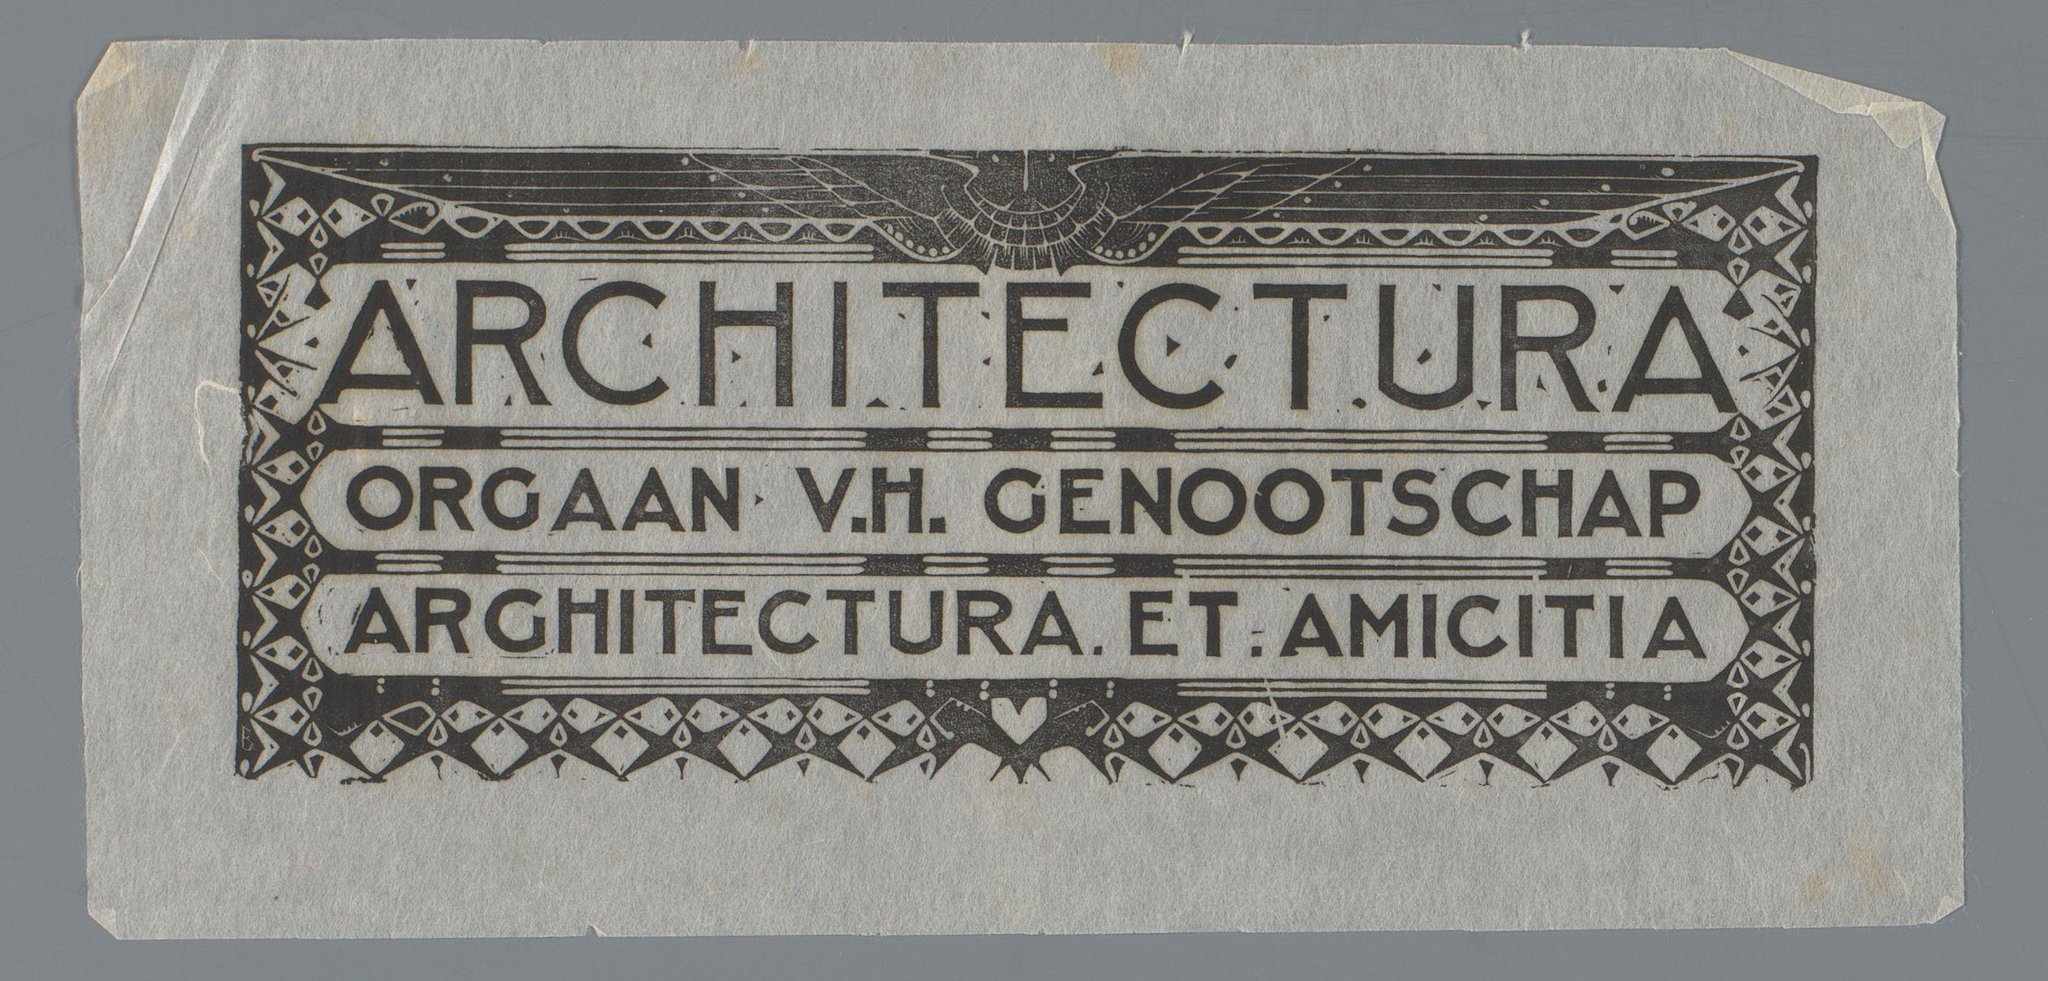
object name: print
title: Titelhoofd voor: Architectura, orgaan van het genootschap Architectura et Amicitia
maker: karel petrus cornelis de bazel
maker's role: draughtsman, print maker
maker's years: 1869-1923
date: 1897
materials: paper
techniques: woodcut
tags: book-cover, binding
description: Titelhoofd ontworpen als voor het jubileumnummer ter ere van de 70ste geboortedag van Pierre Cuypers (Architectura 5 (1897), no. 20, 16 mei 1897). Later is dit titelhoofd ook gebruikt voor gewone nummers van 'Architectura' (van 1 januari 1898 tot en met 31 december 1898).